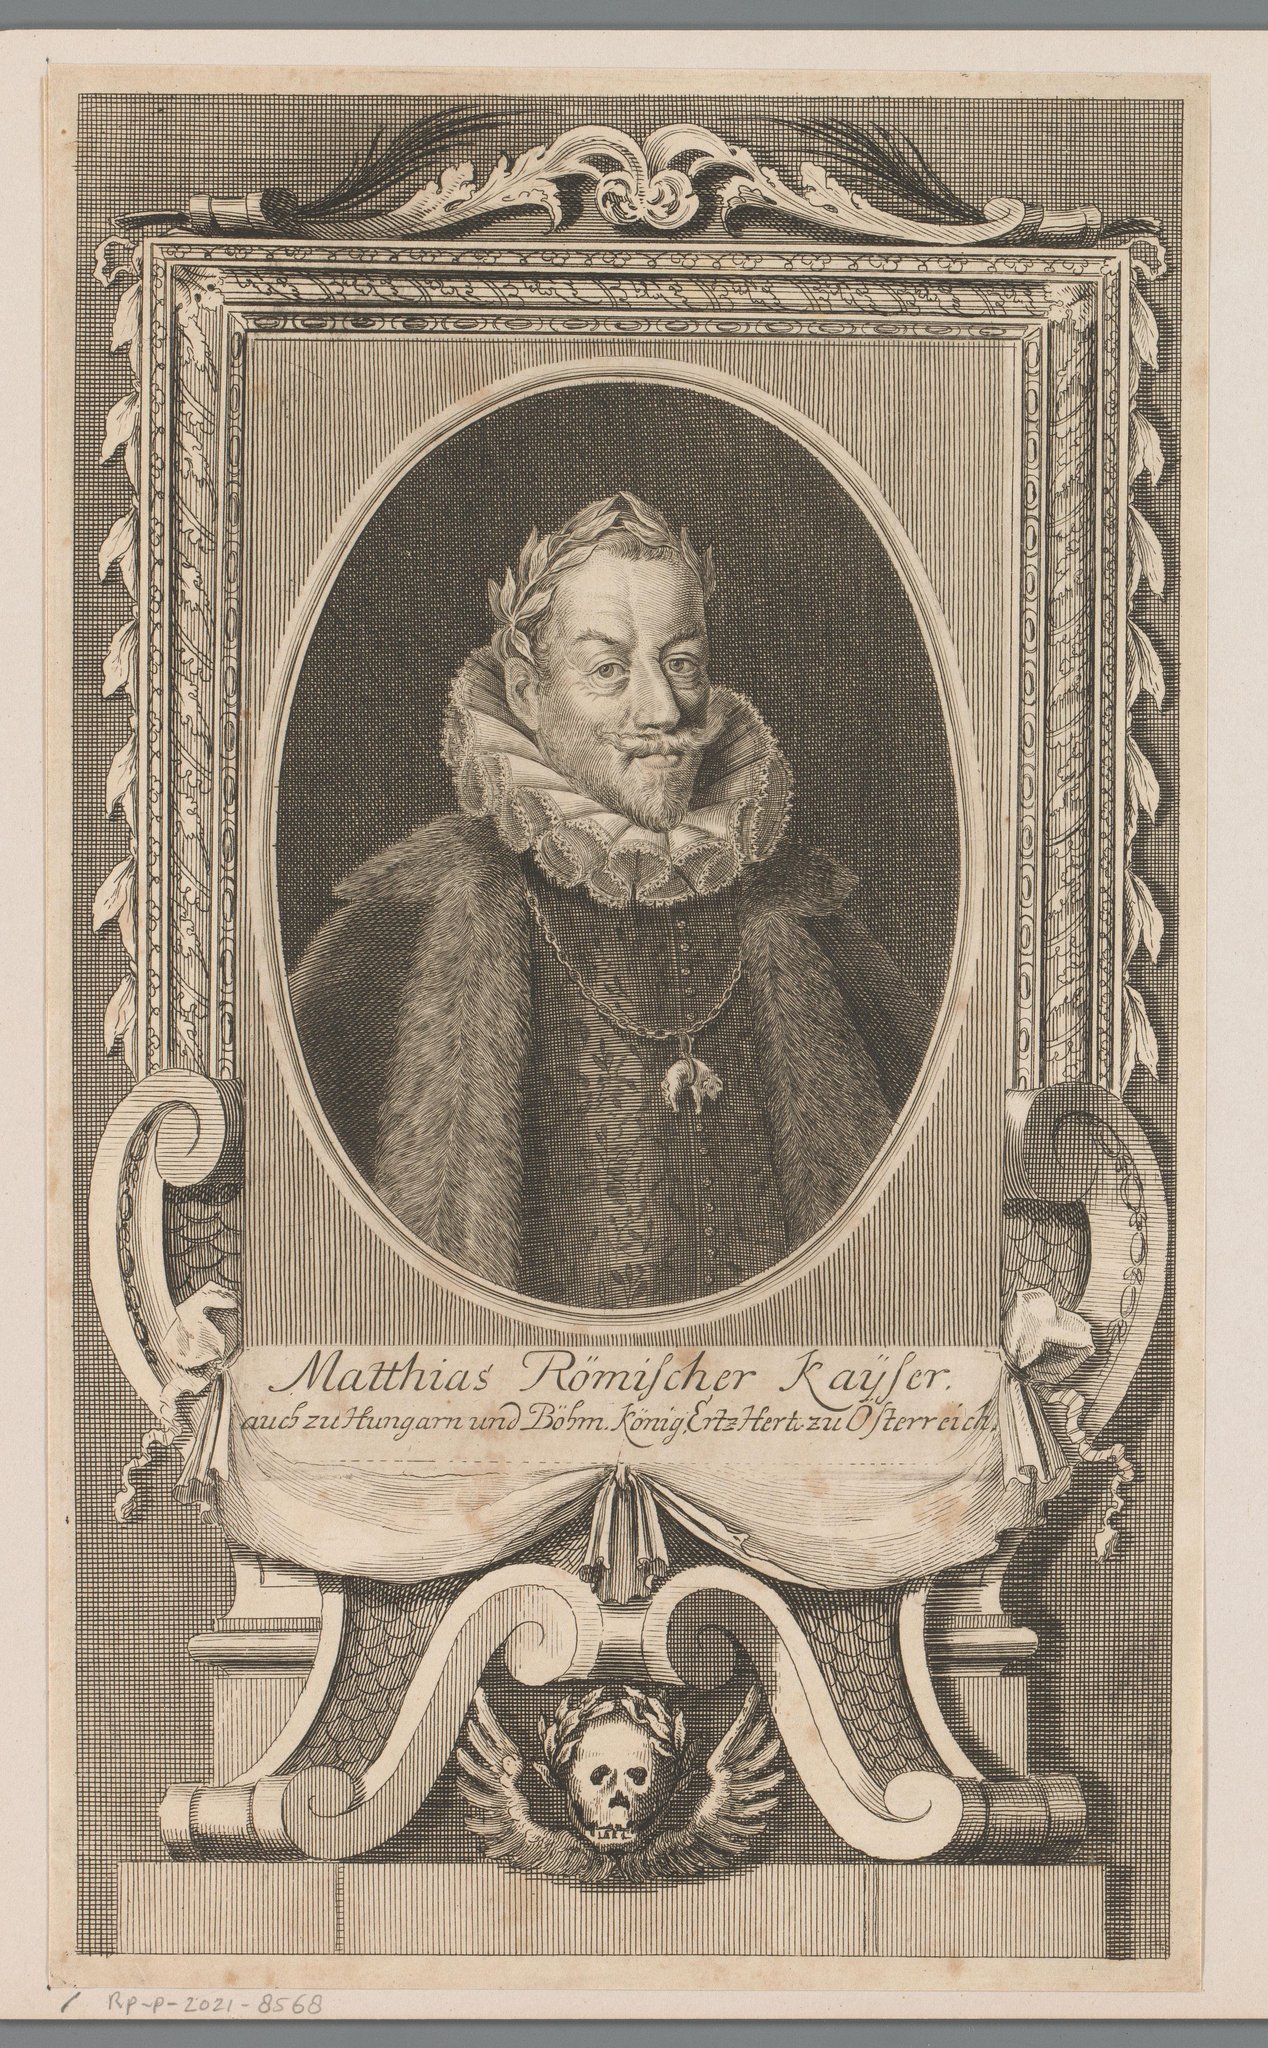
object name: book illustration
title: Portret van keizer Matthias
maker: johann friedrich rosbach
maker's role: print maker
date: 1721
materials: paper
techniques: engraving, etching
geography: germany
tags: vienna, matthias van oostenrijk (rooms-duits keizer), (human) skull, historical persons, knighthood order of the golden fleece, emperor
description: Prent waarschijnlijk uit: Khevenhüller, Franz Christoph. Conterfet Kupfferstich (...). Leipzig: Moritz Georg Weidmann, 1721, dl. 1. De prent is ook met een andere omlijsting en met nummering gebruikt in dit werk.